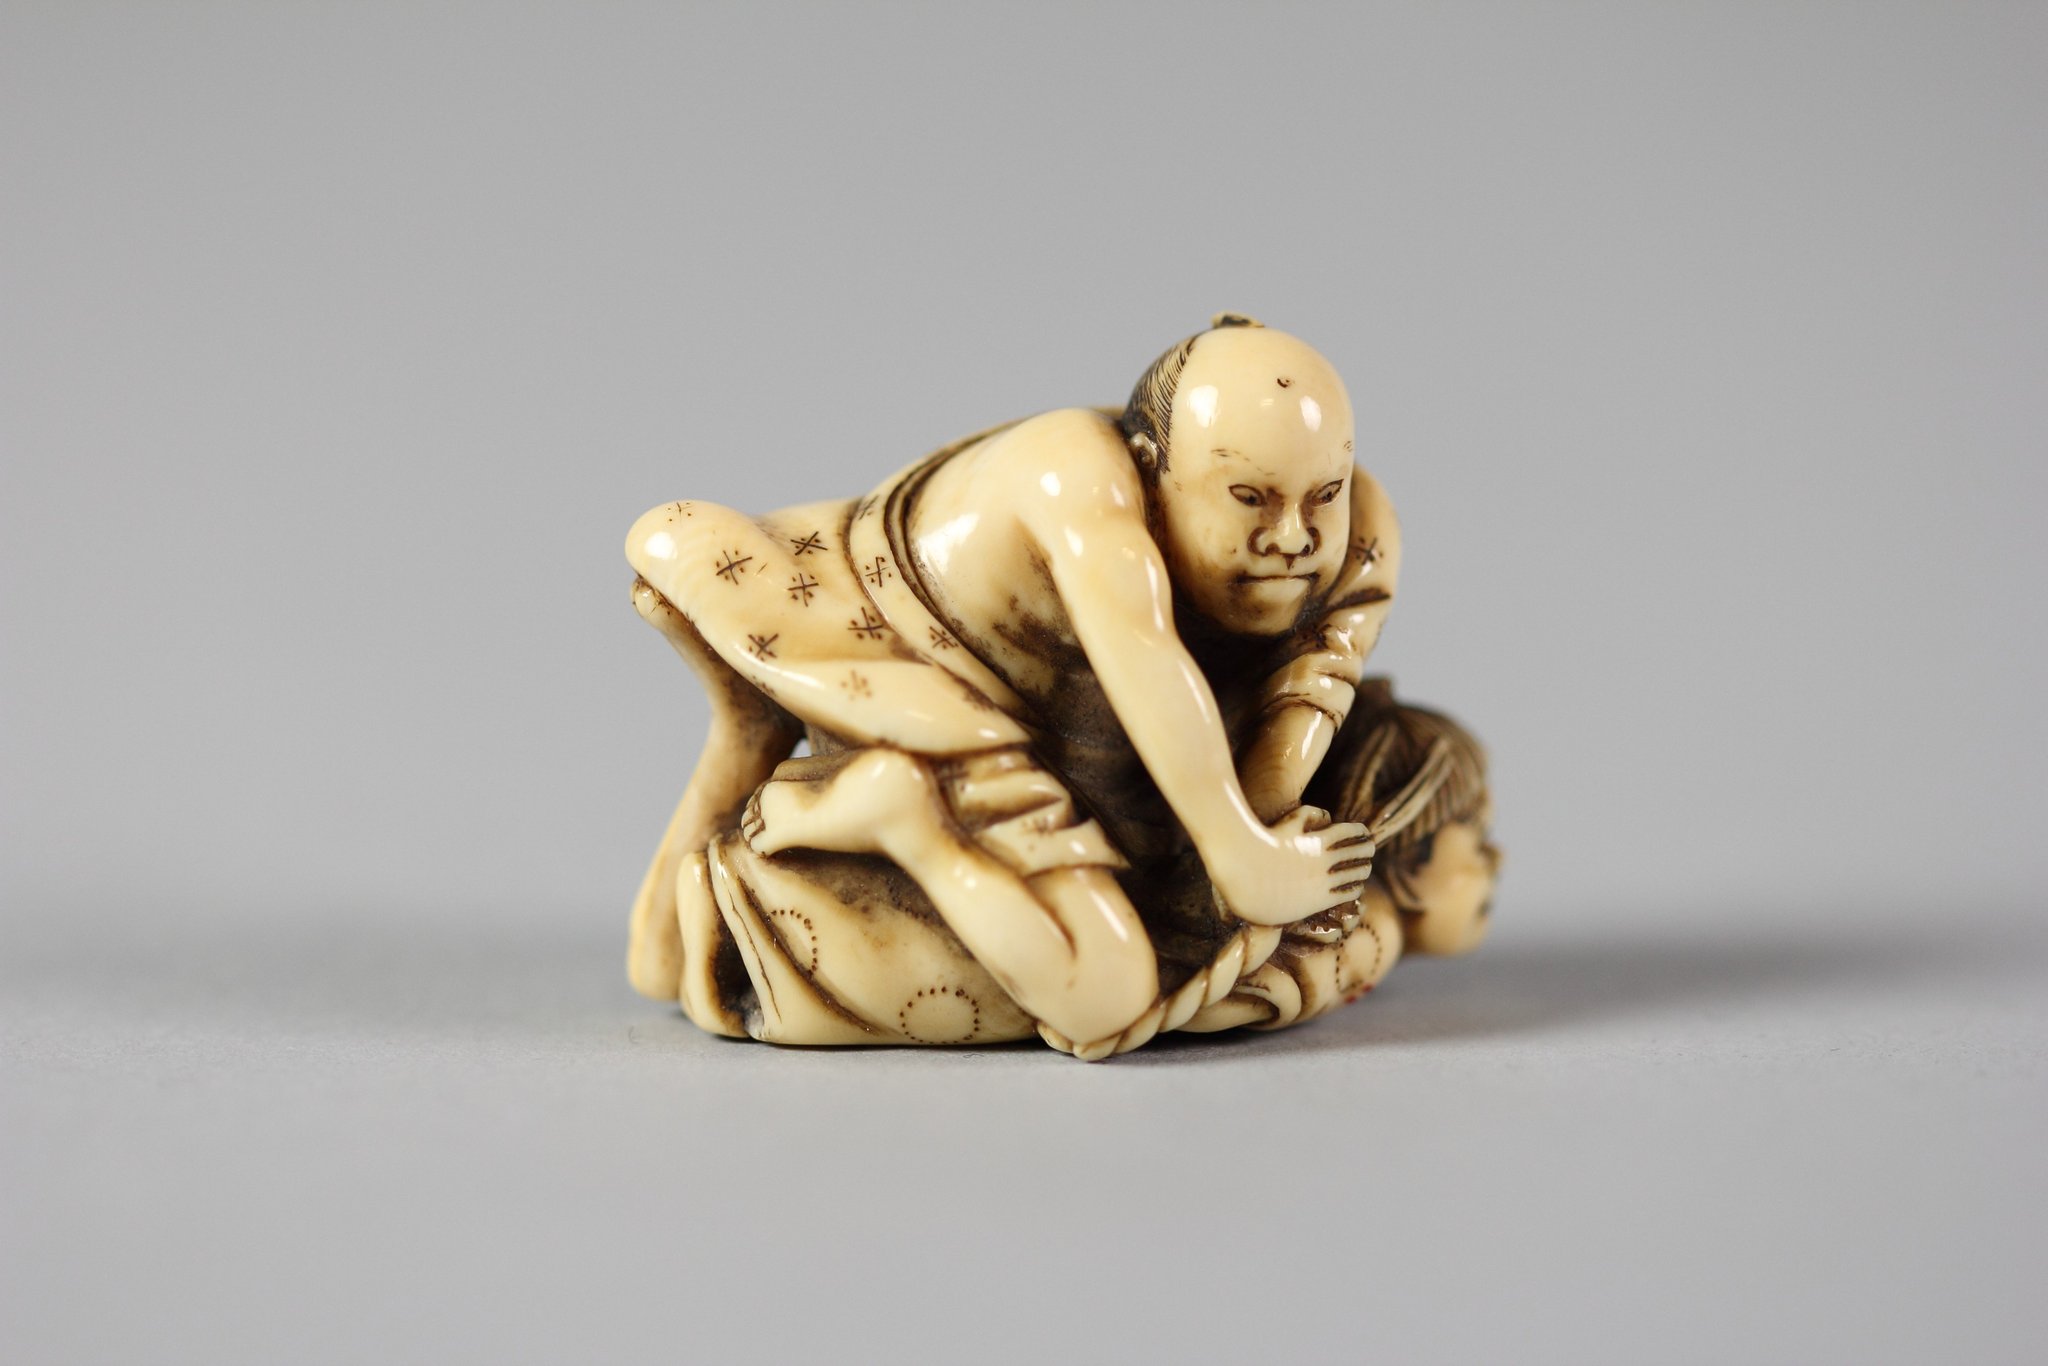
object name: netsuke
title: Netsuke of Two Wrestlers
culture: japanese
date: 1801-1900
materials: ivory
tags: men,sports